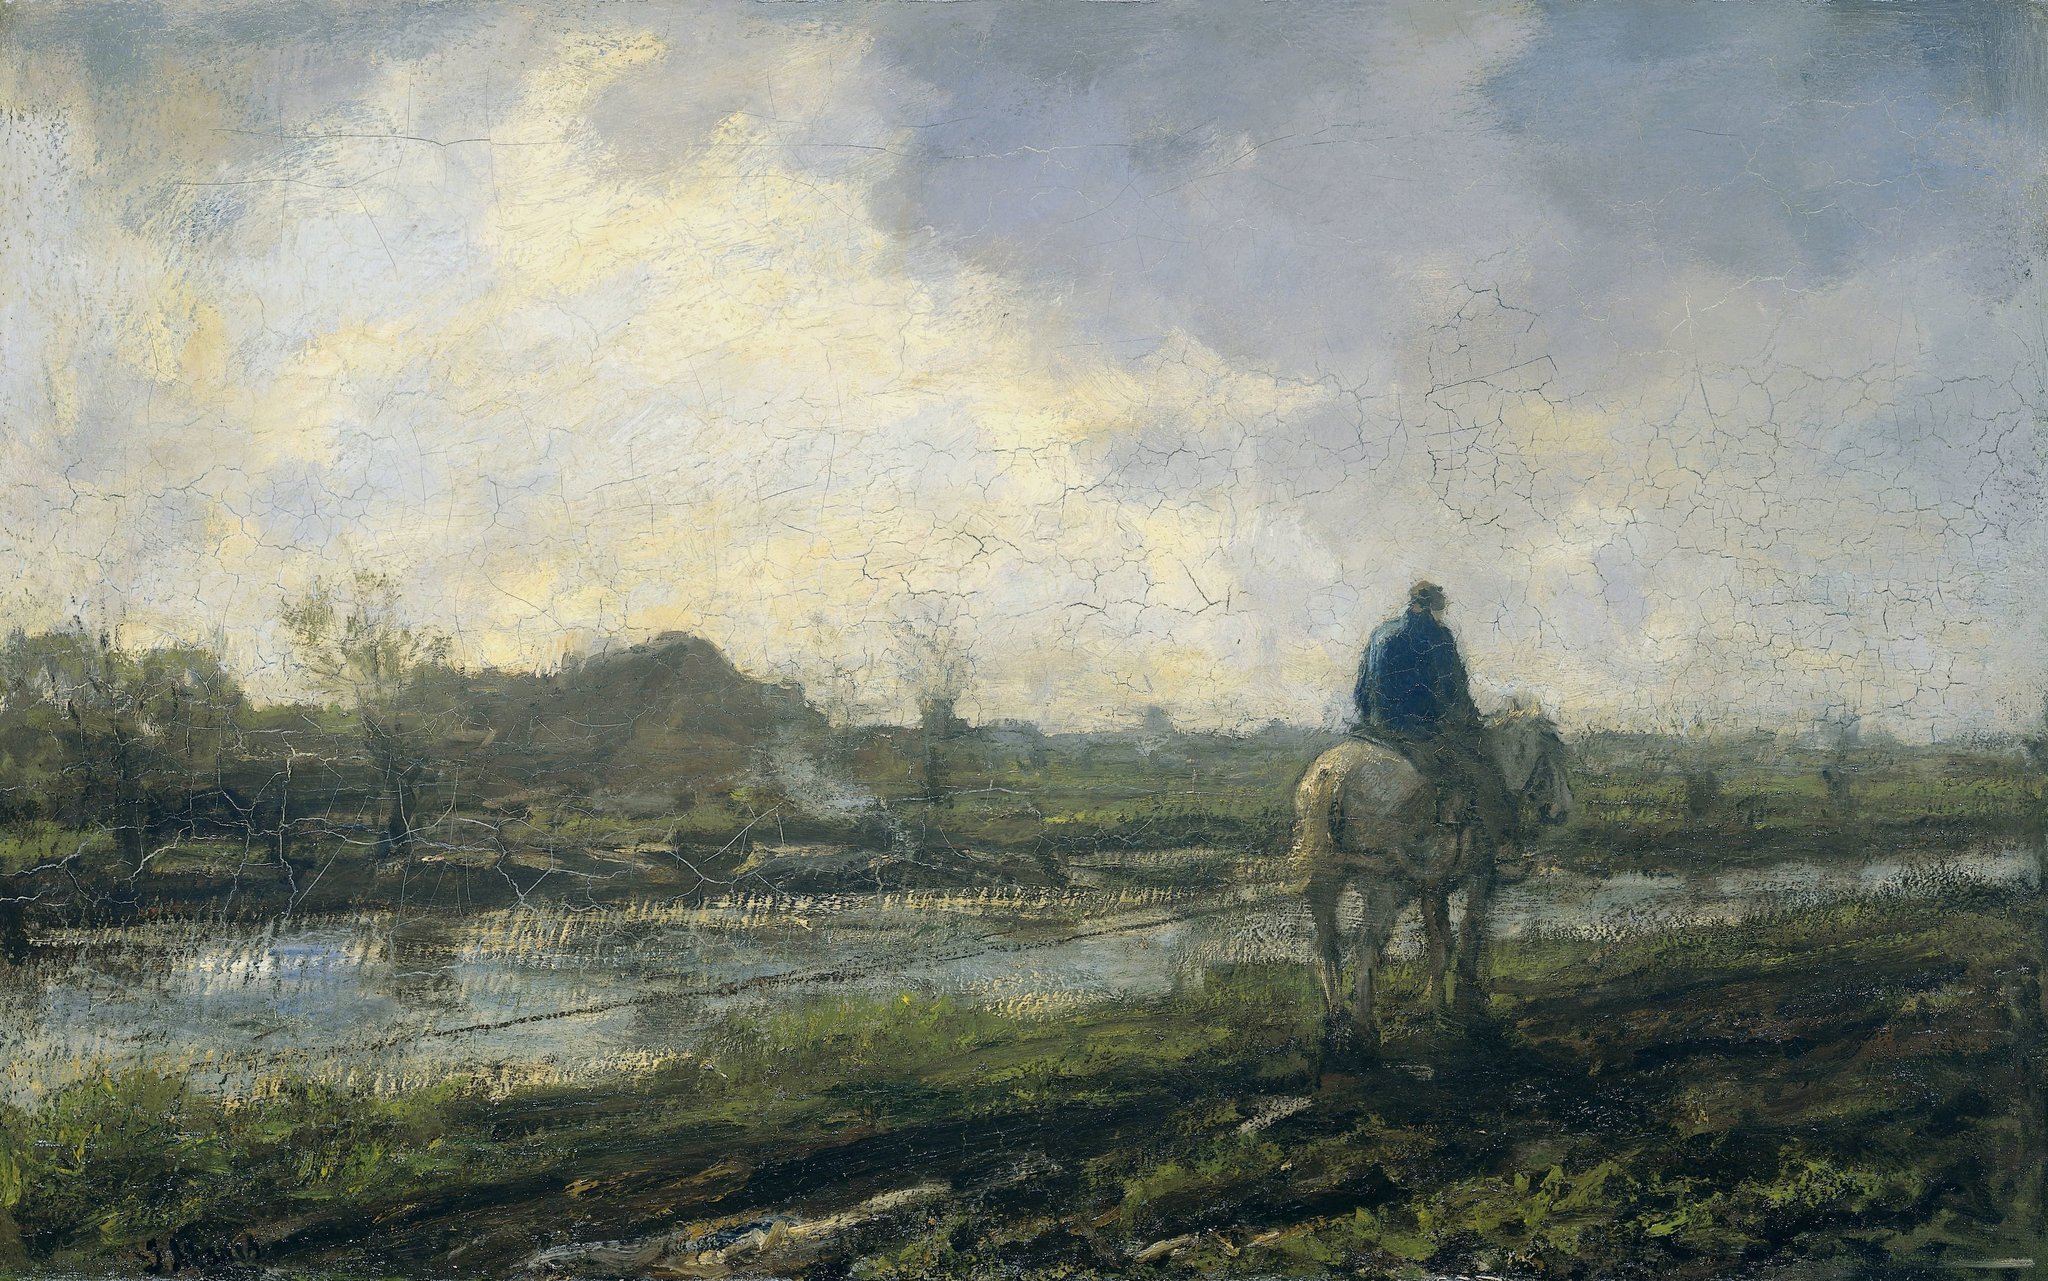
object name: painting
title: Jaagpad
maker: jacob maris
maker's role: draughtsman, painter, print maker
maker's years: 1837-1899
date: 1894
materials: canvas, oil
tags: tow-boat, towing-barge, horse, towing path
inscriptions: signature: ‘J. Maris’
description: Landschap met een jager te paard op het jaagpad langs een kanaal.